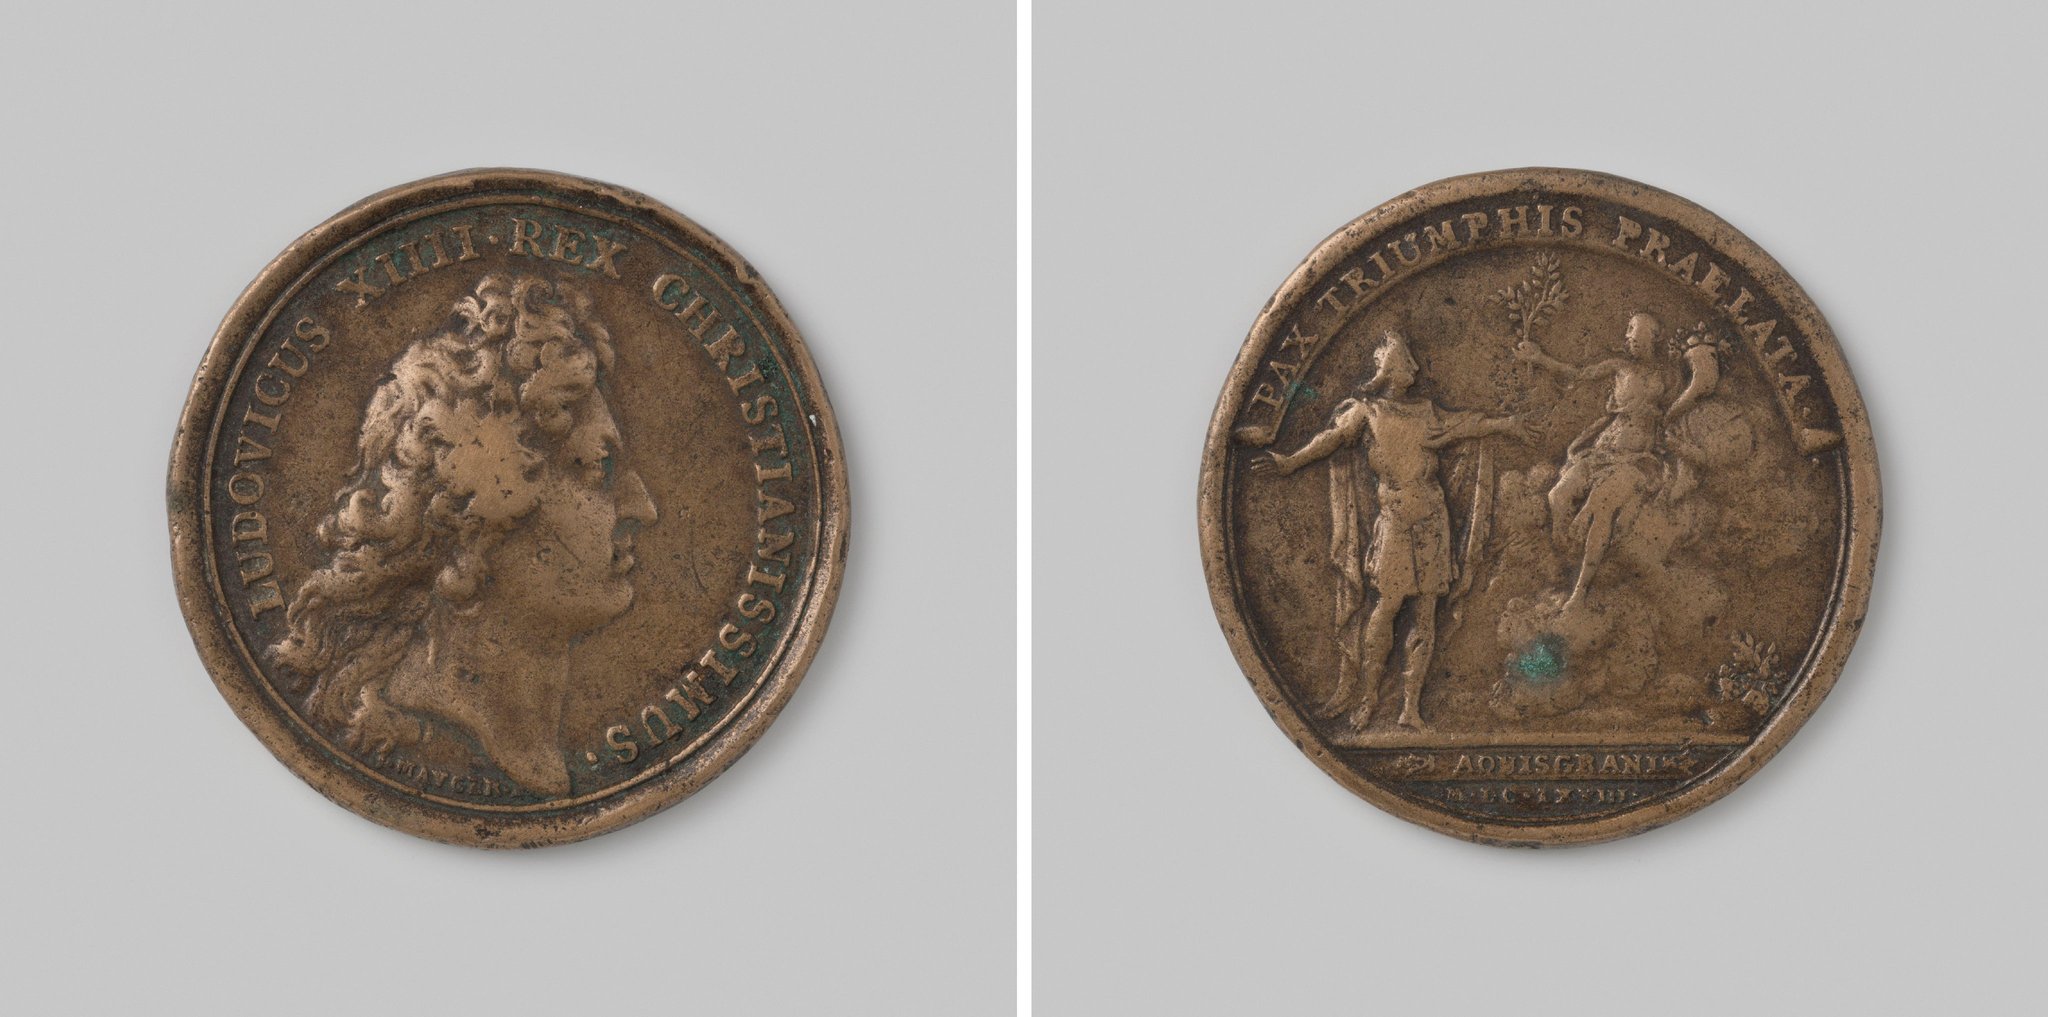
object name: history medal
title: Vrede van Aken 1668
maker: jean mauger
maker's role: medailleur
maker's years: 1648-1722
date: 1668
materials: bronze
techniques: casting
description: Bronzen afgietsel van een penning, op de voorzijde het portret van Koning Lodewijk XIV naar rechts met omschrift, op de keerzijde de Franse koning die een vredestak ontvangt van Pax tronend in de wolken, met omschrift en afsnedetekst.